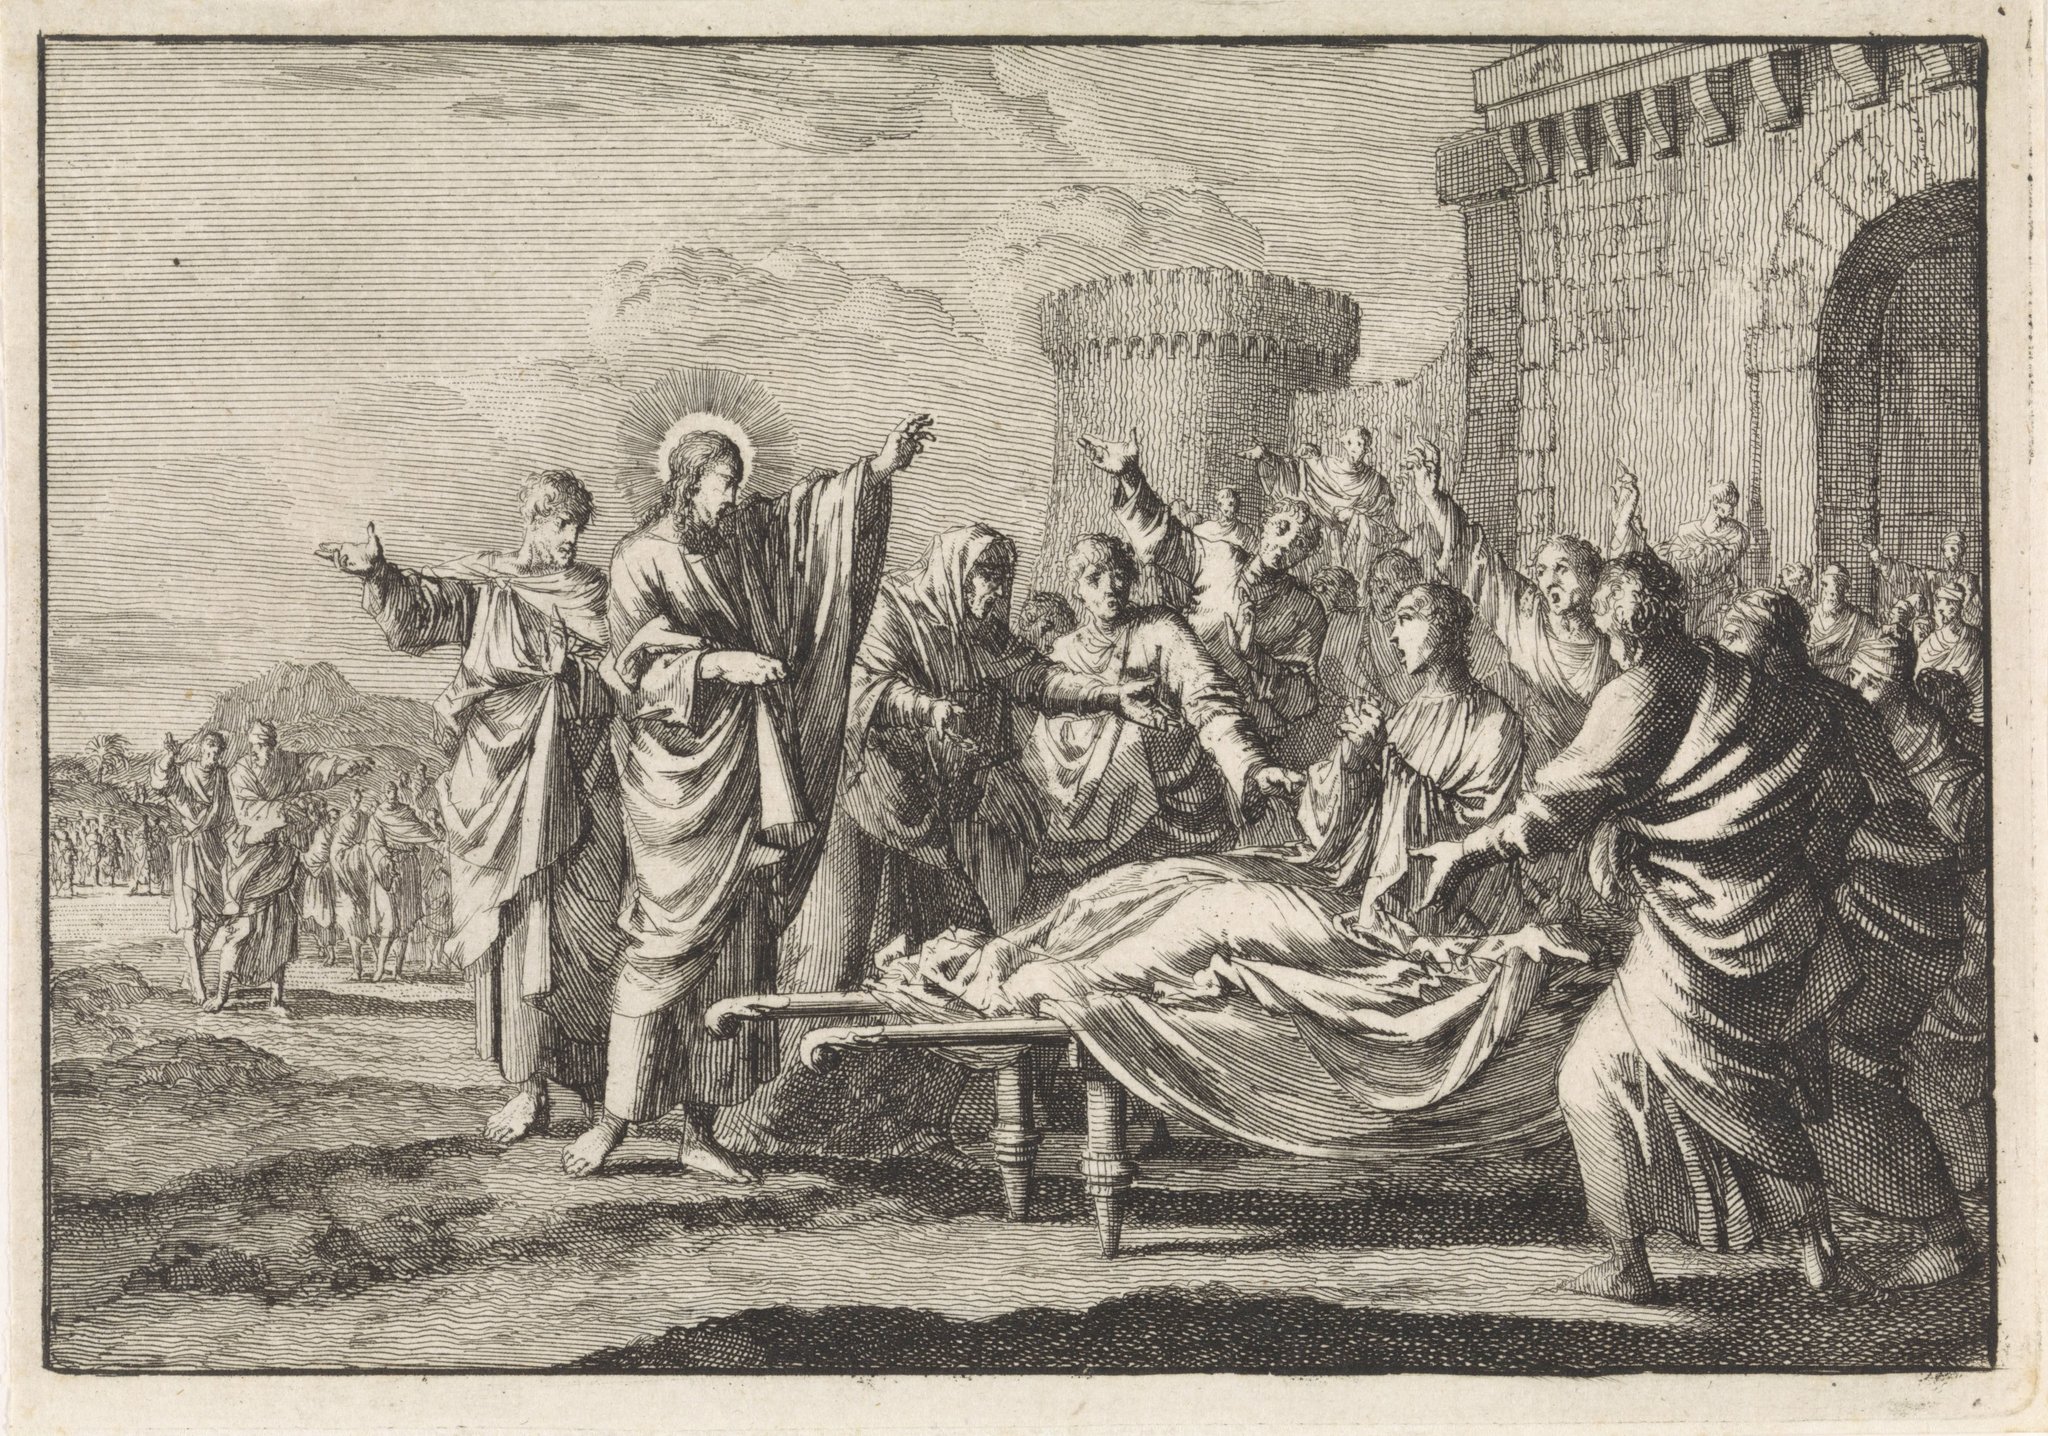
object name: print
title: Opwekking van de jongeling te Naïn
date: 1703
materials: paper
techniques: etching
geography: haarlem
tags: christ touches the bier of the son of the widow of nain: the young man sits up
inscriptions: collector's mark: Lugt 2228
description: Proefdruk van een boekillustratie voor David Martin. Historie des Ouden en Nieuwen Testaments. Amsterdam, Pieter Mortier, 1703. Deel II. De boekillustraties voor de Mortierbijbel hebben verschillende staten en kopieën, waarbij de chronologische volgorde moeilijk te achterhalen valt. Als boekillustraties werden ze bovendien herhaaldelijk opnieuw gebruikt voor andere boekwerken.